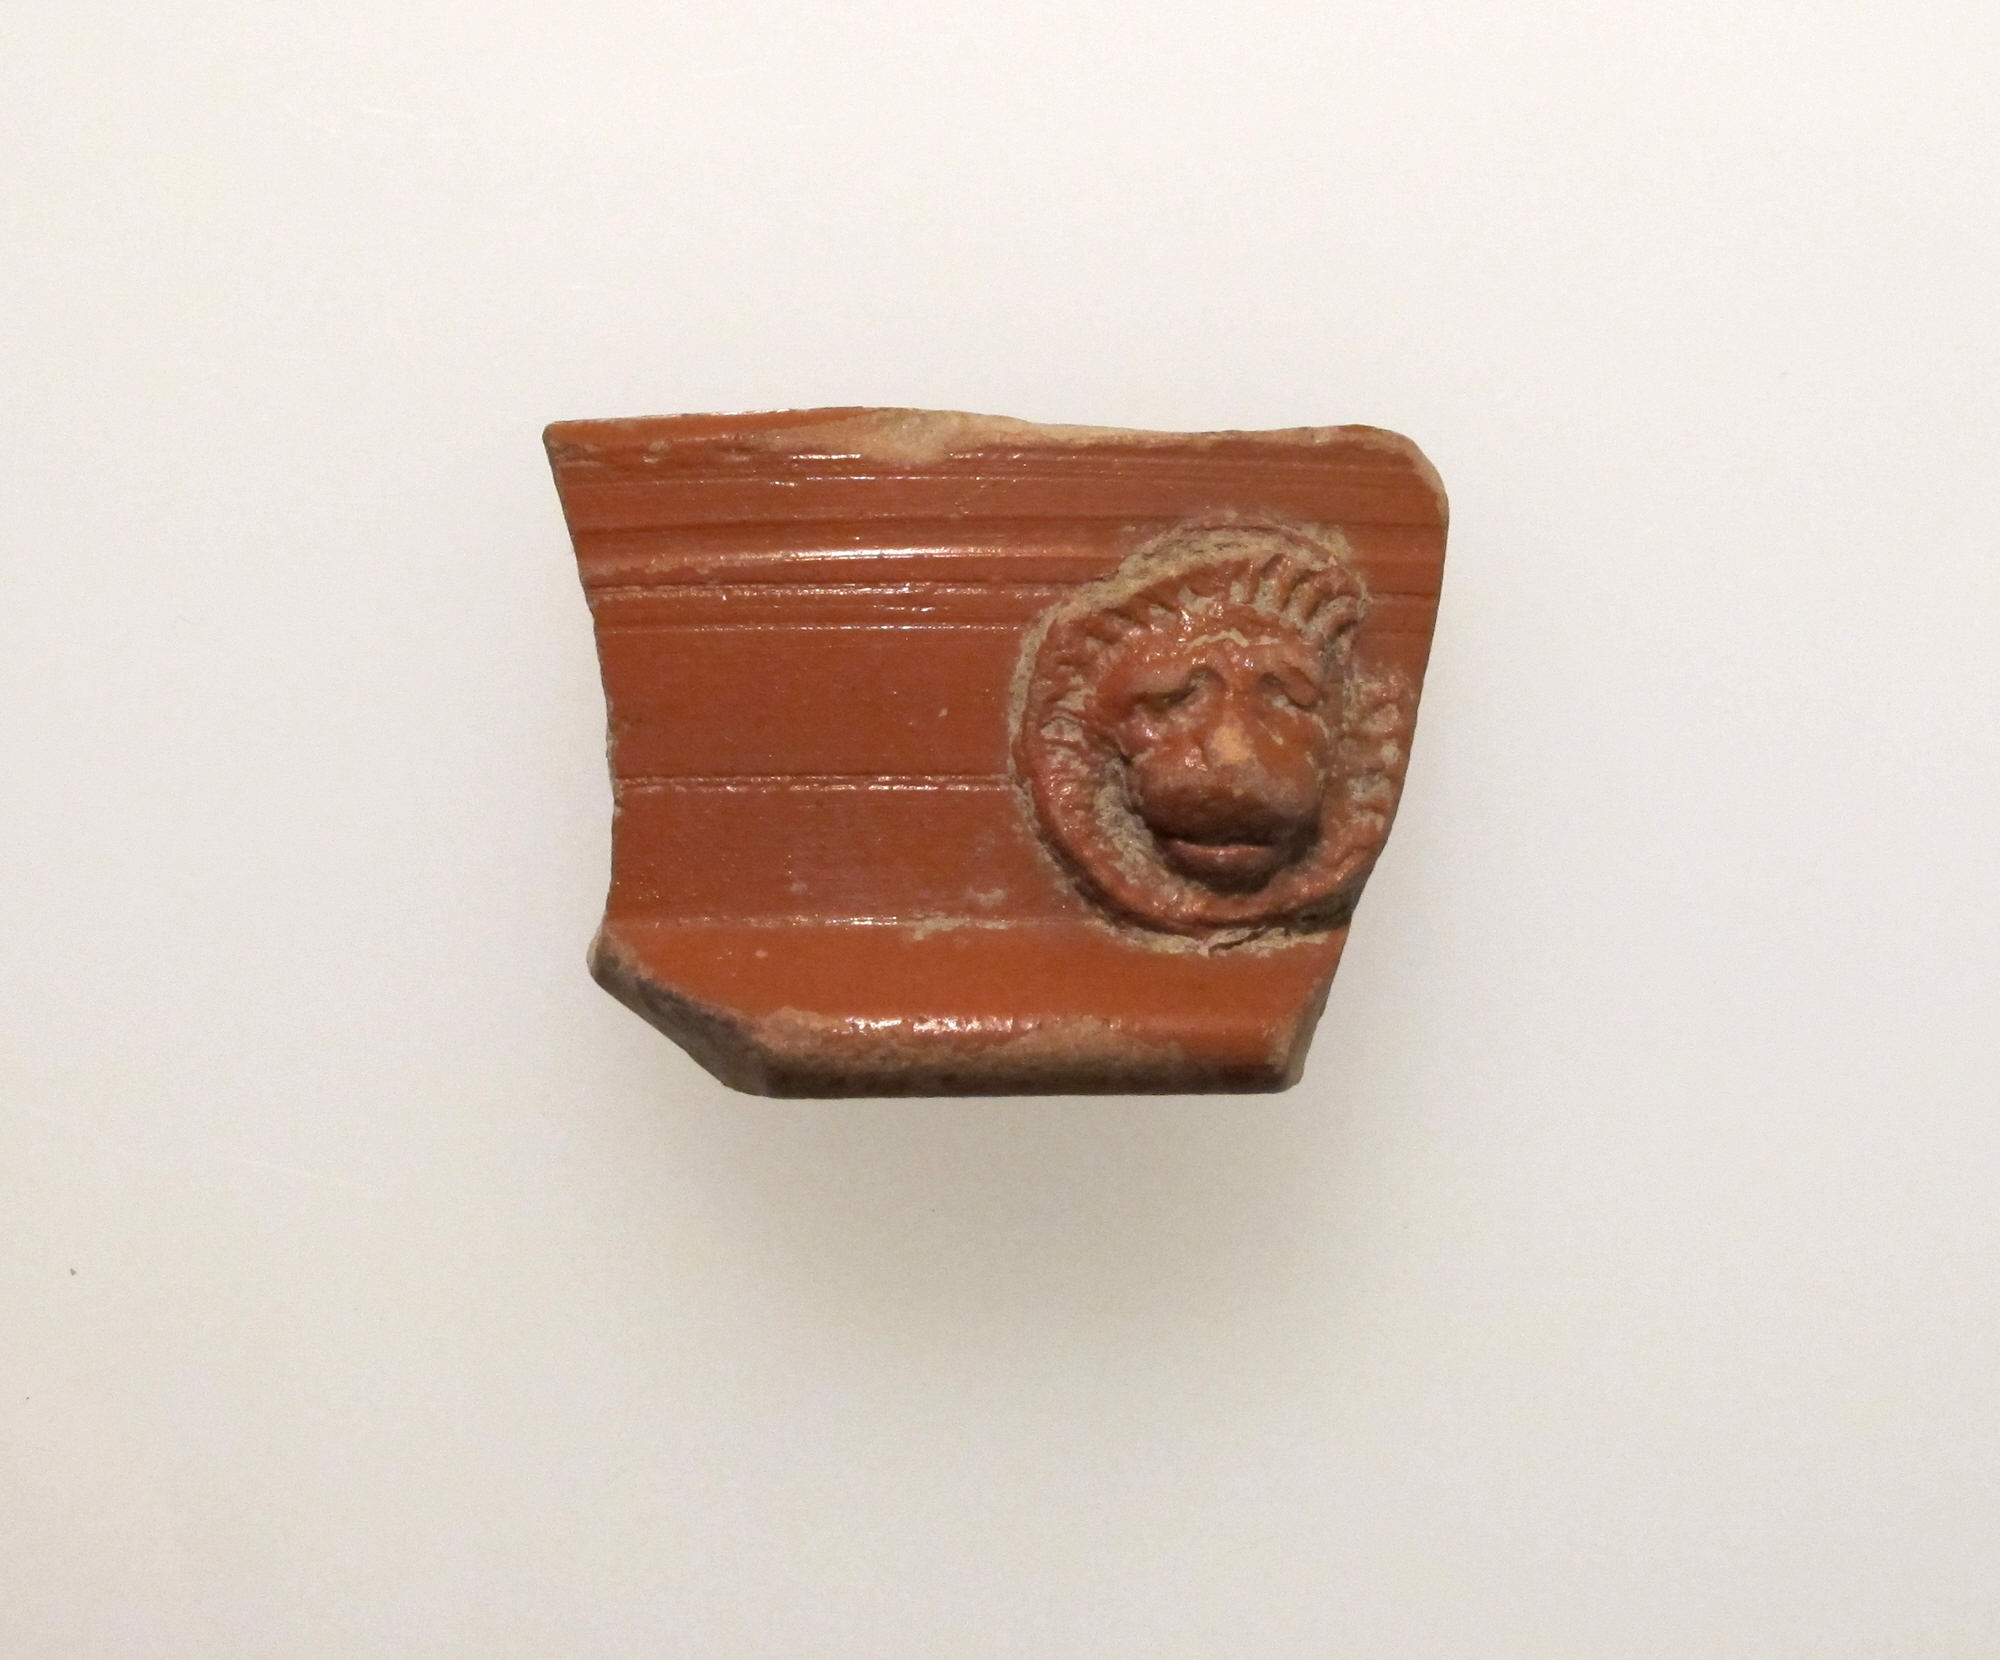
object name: vase fragment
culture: roman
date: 100 BCE-100 CE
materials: terracotta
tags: masks,lions